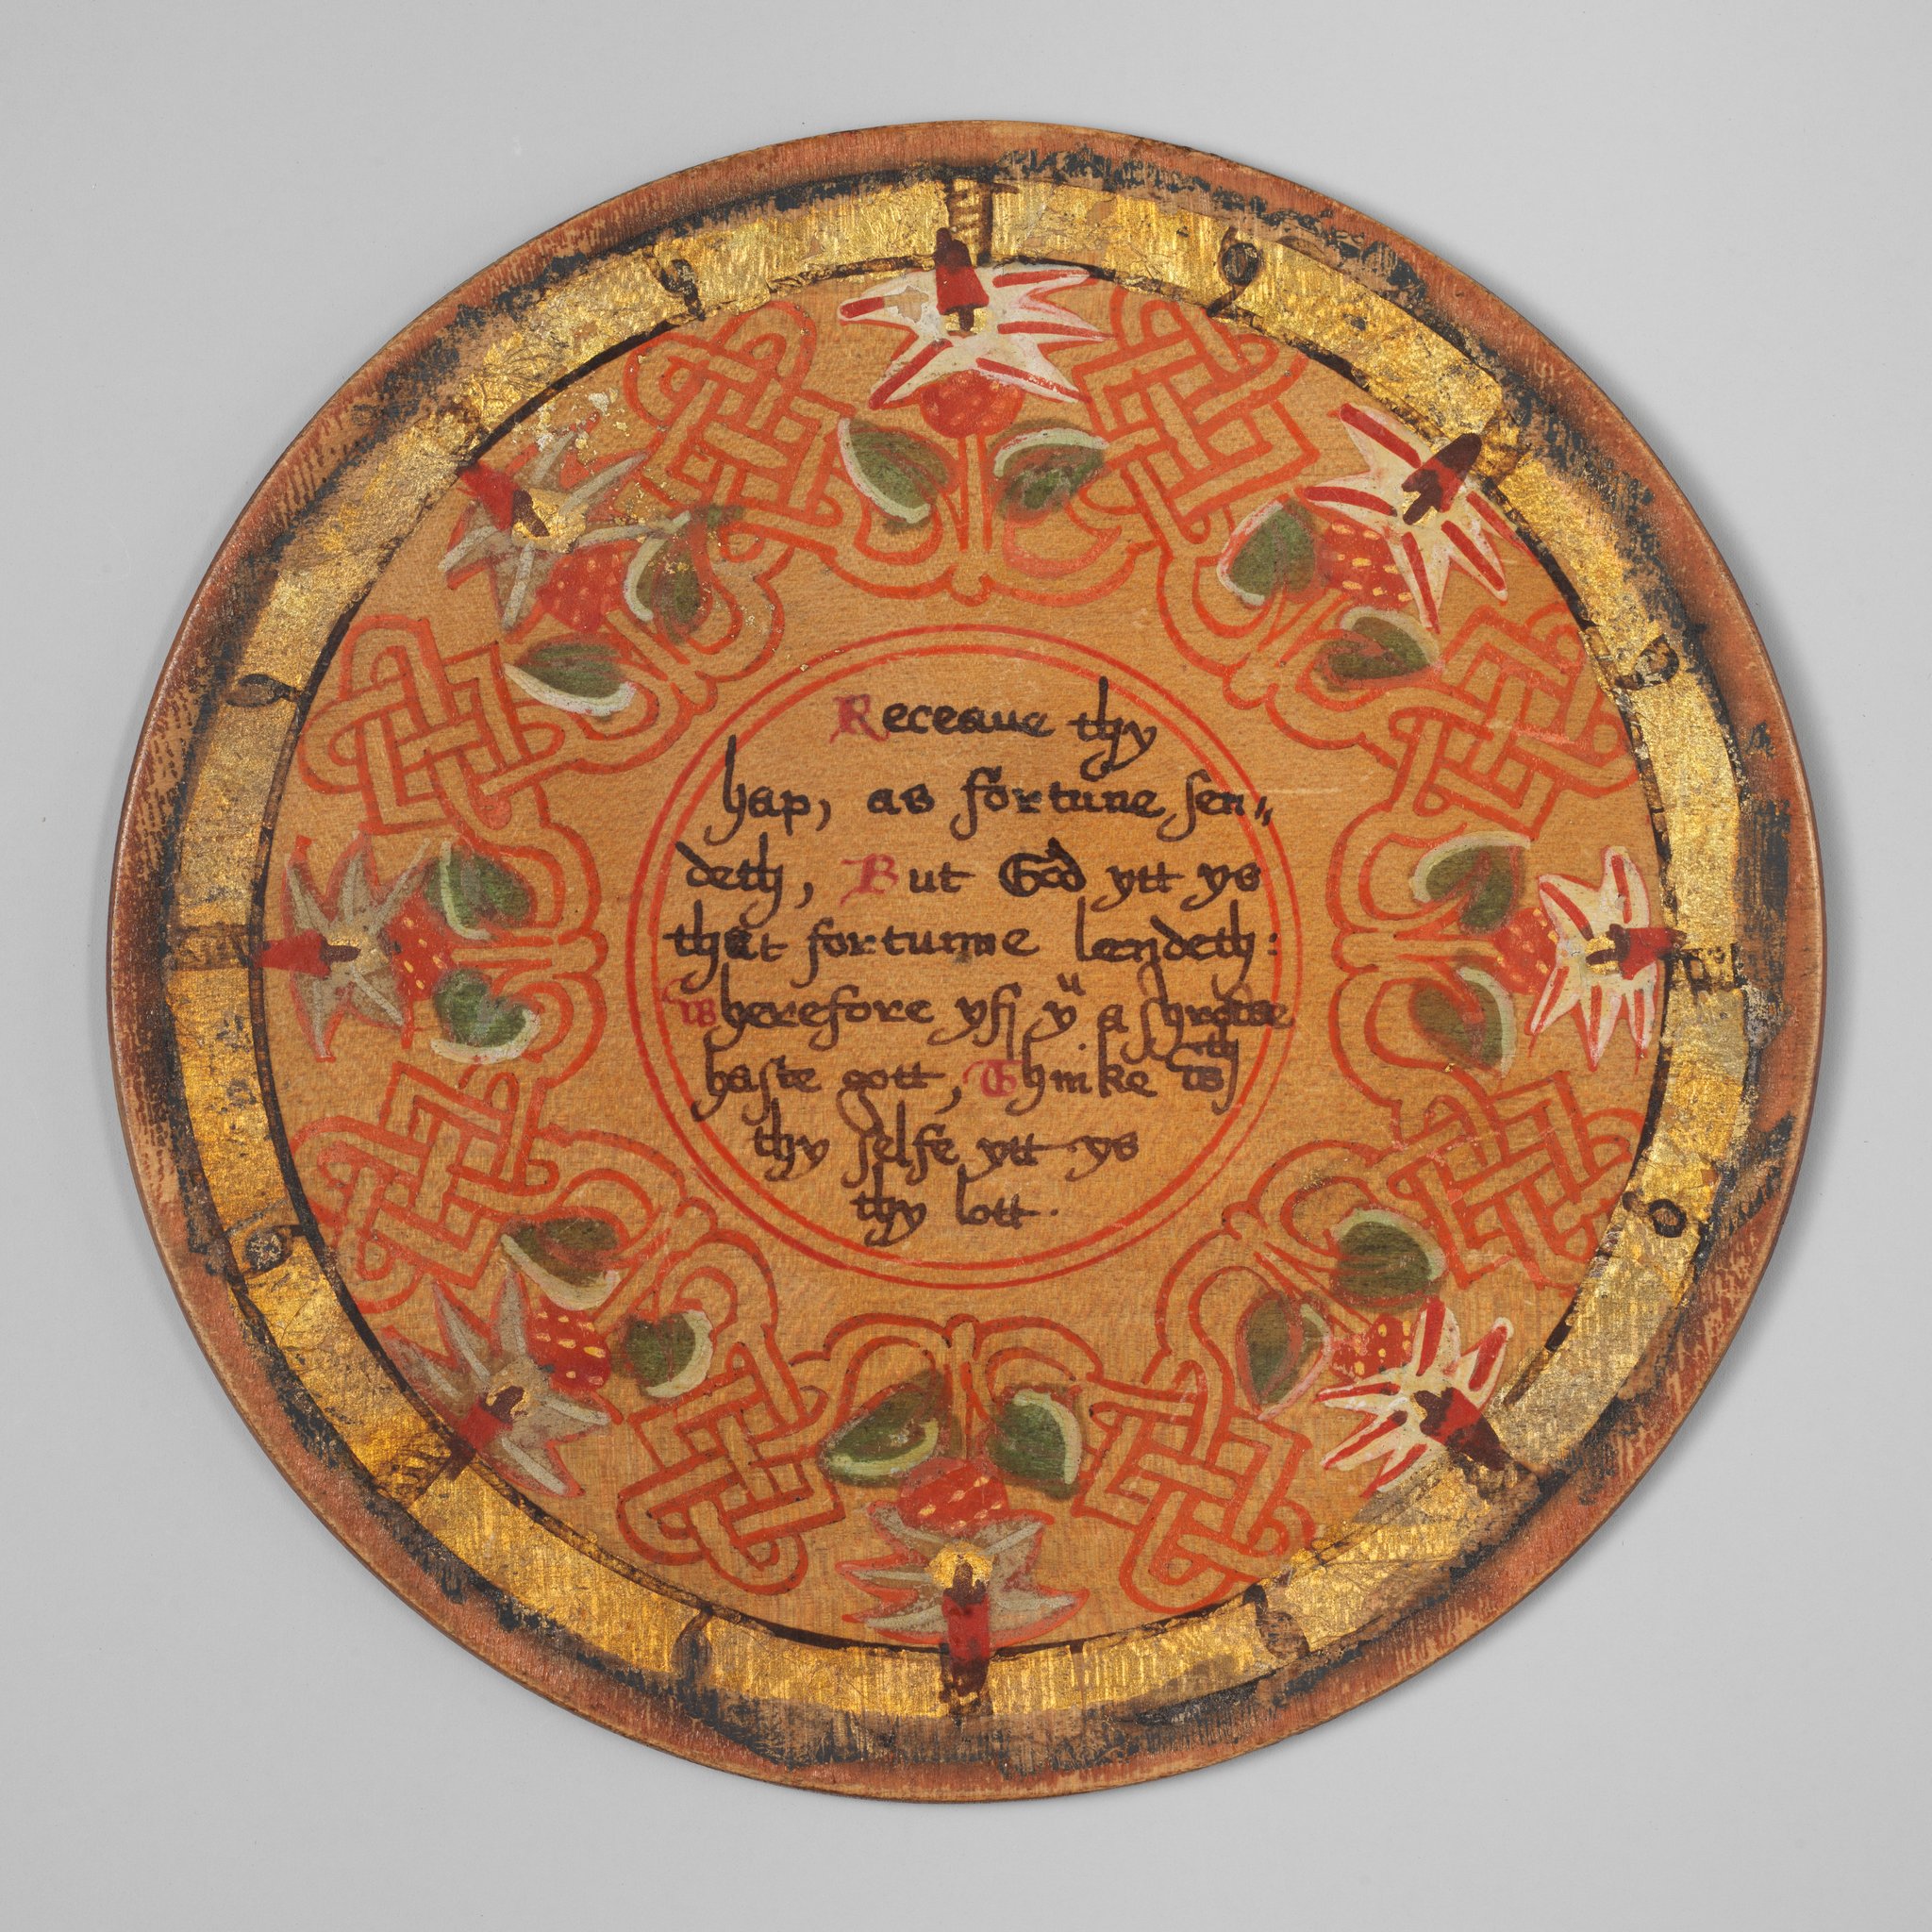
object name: trencher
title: Trencher (one of a set)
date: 1567-1633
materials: ink, wood, varnish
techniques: painting, silvered